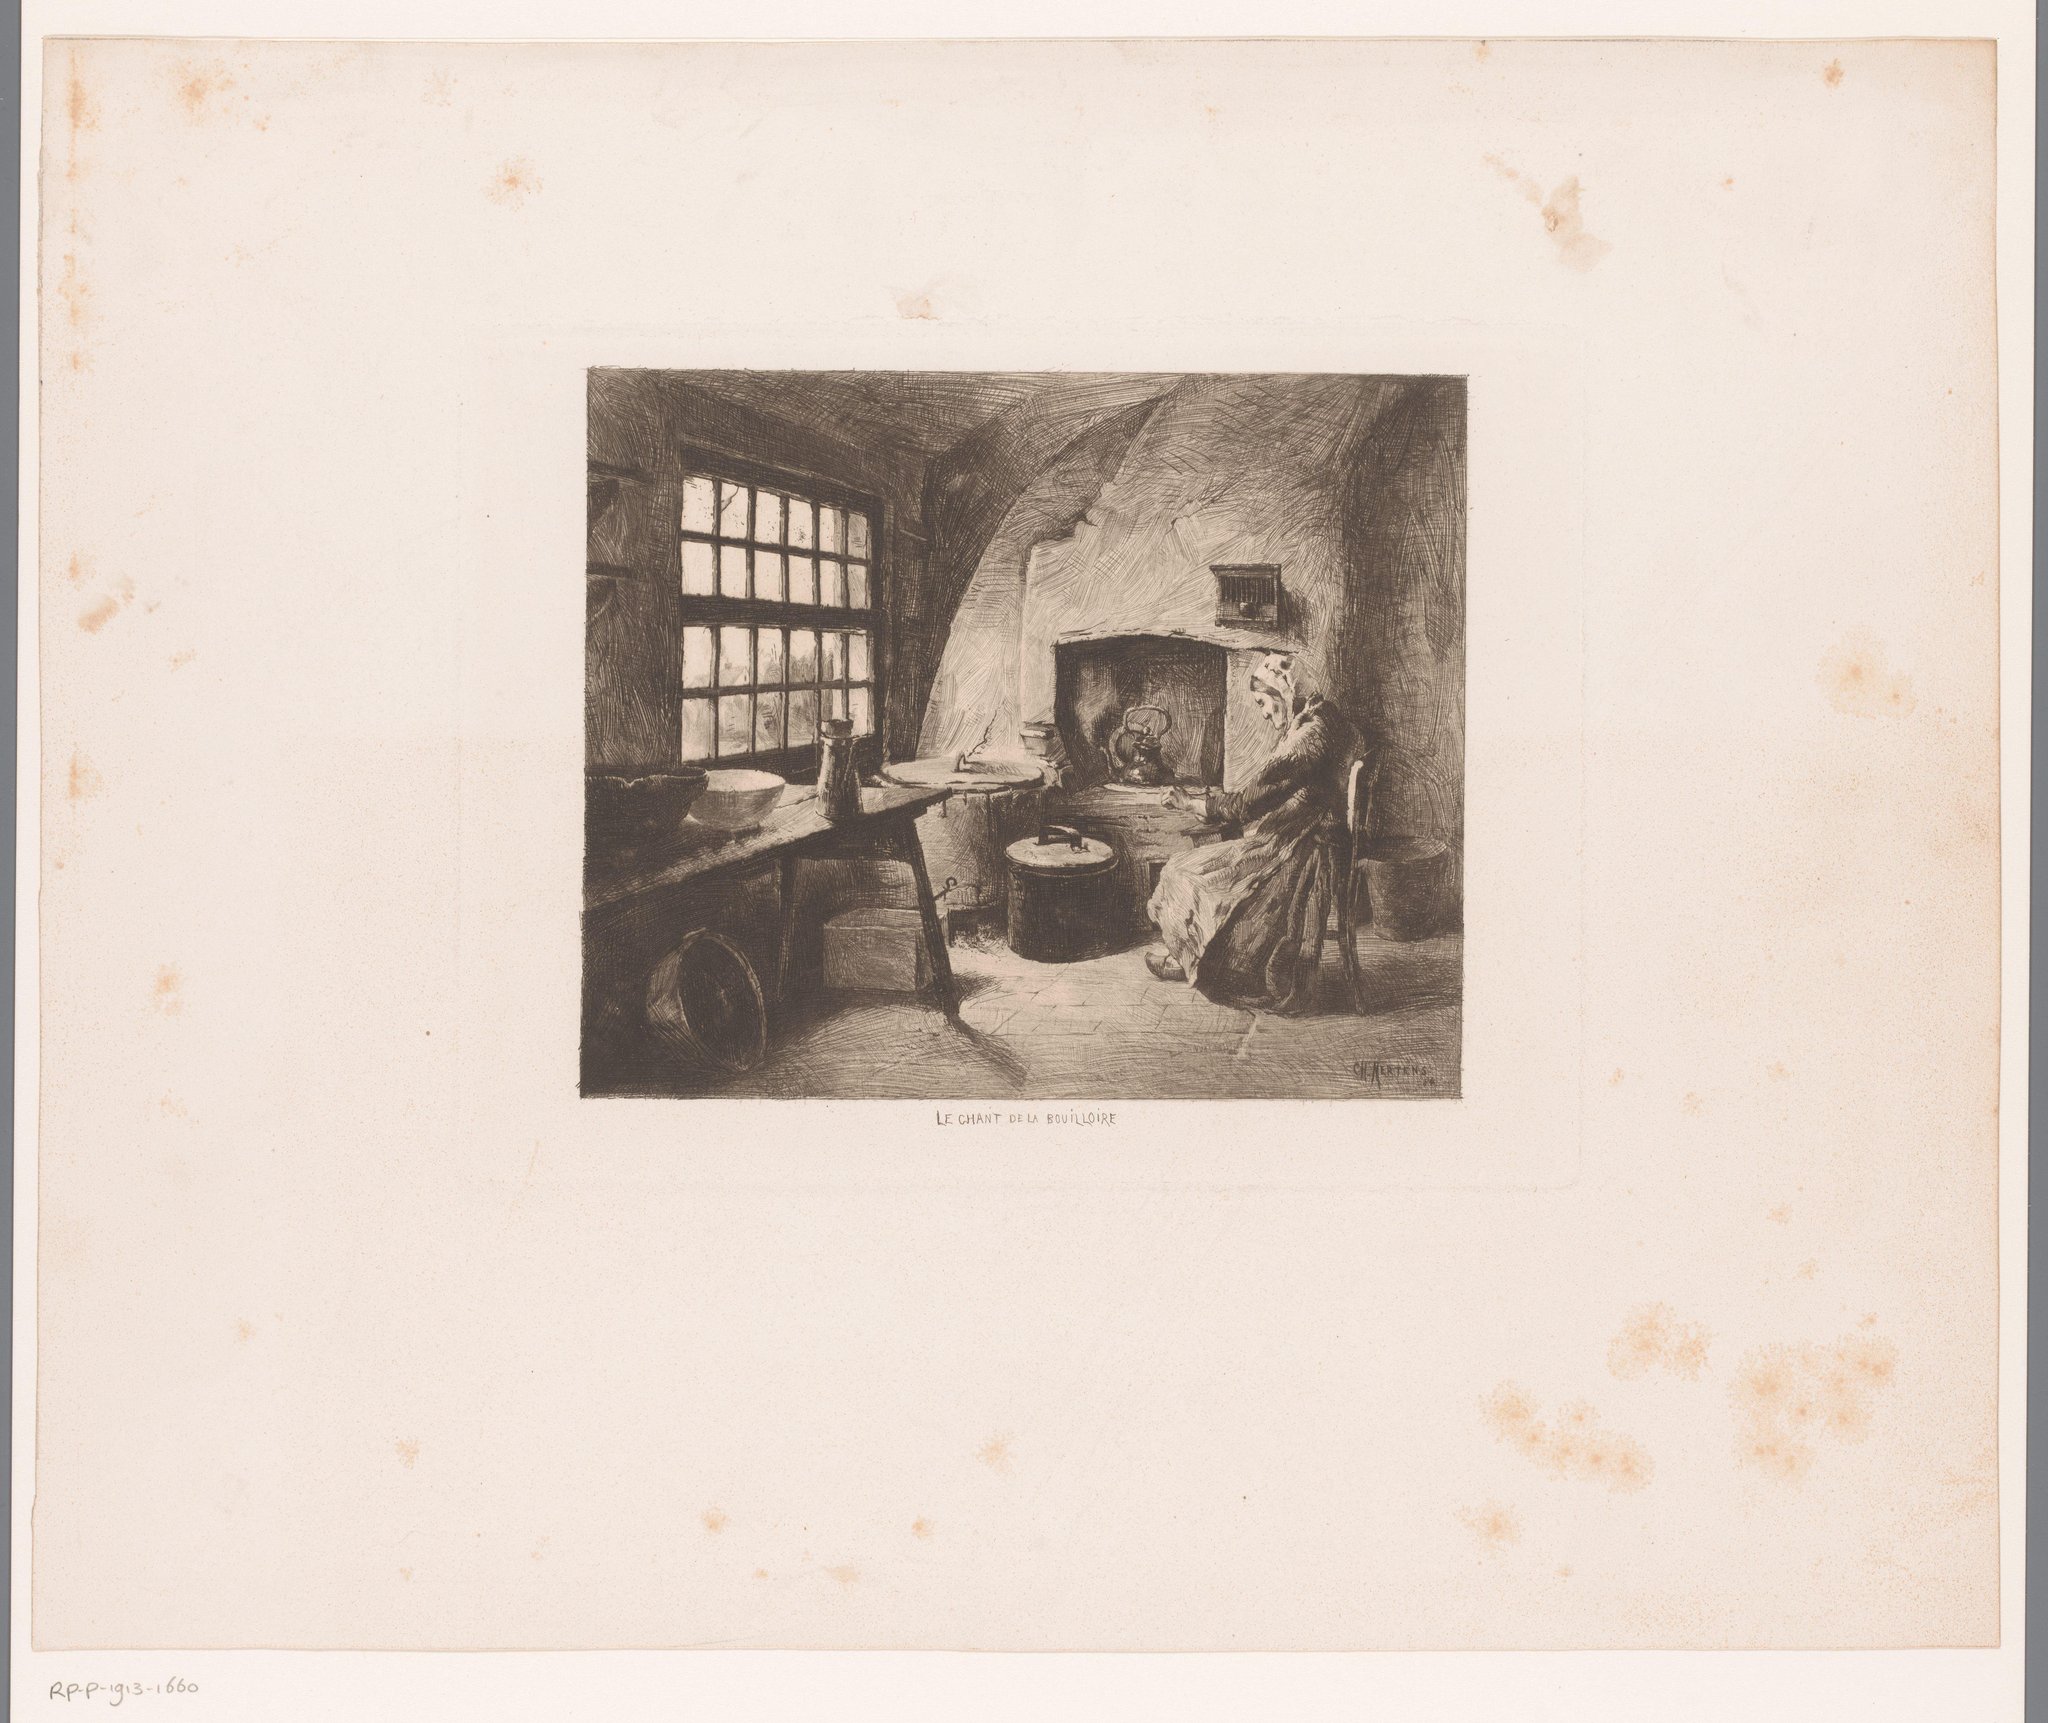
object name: print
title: Le chant de la bouilloire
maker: charles mertens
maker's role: print maker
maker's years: 1865-1919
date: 1884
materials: paper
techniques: drypoint, etching, intaglio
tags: sitting figure - aa - female human figure, kitchen-interior, open fire, fire-place, stove (in kitchen)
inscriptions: collector's mark: Lugt 2228